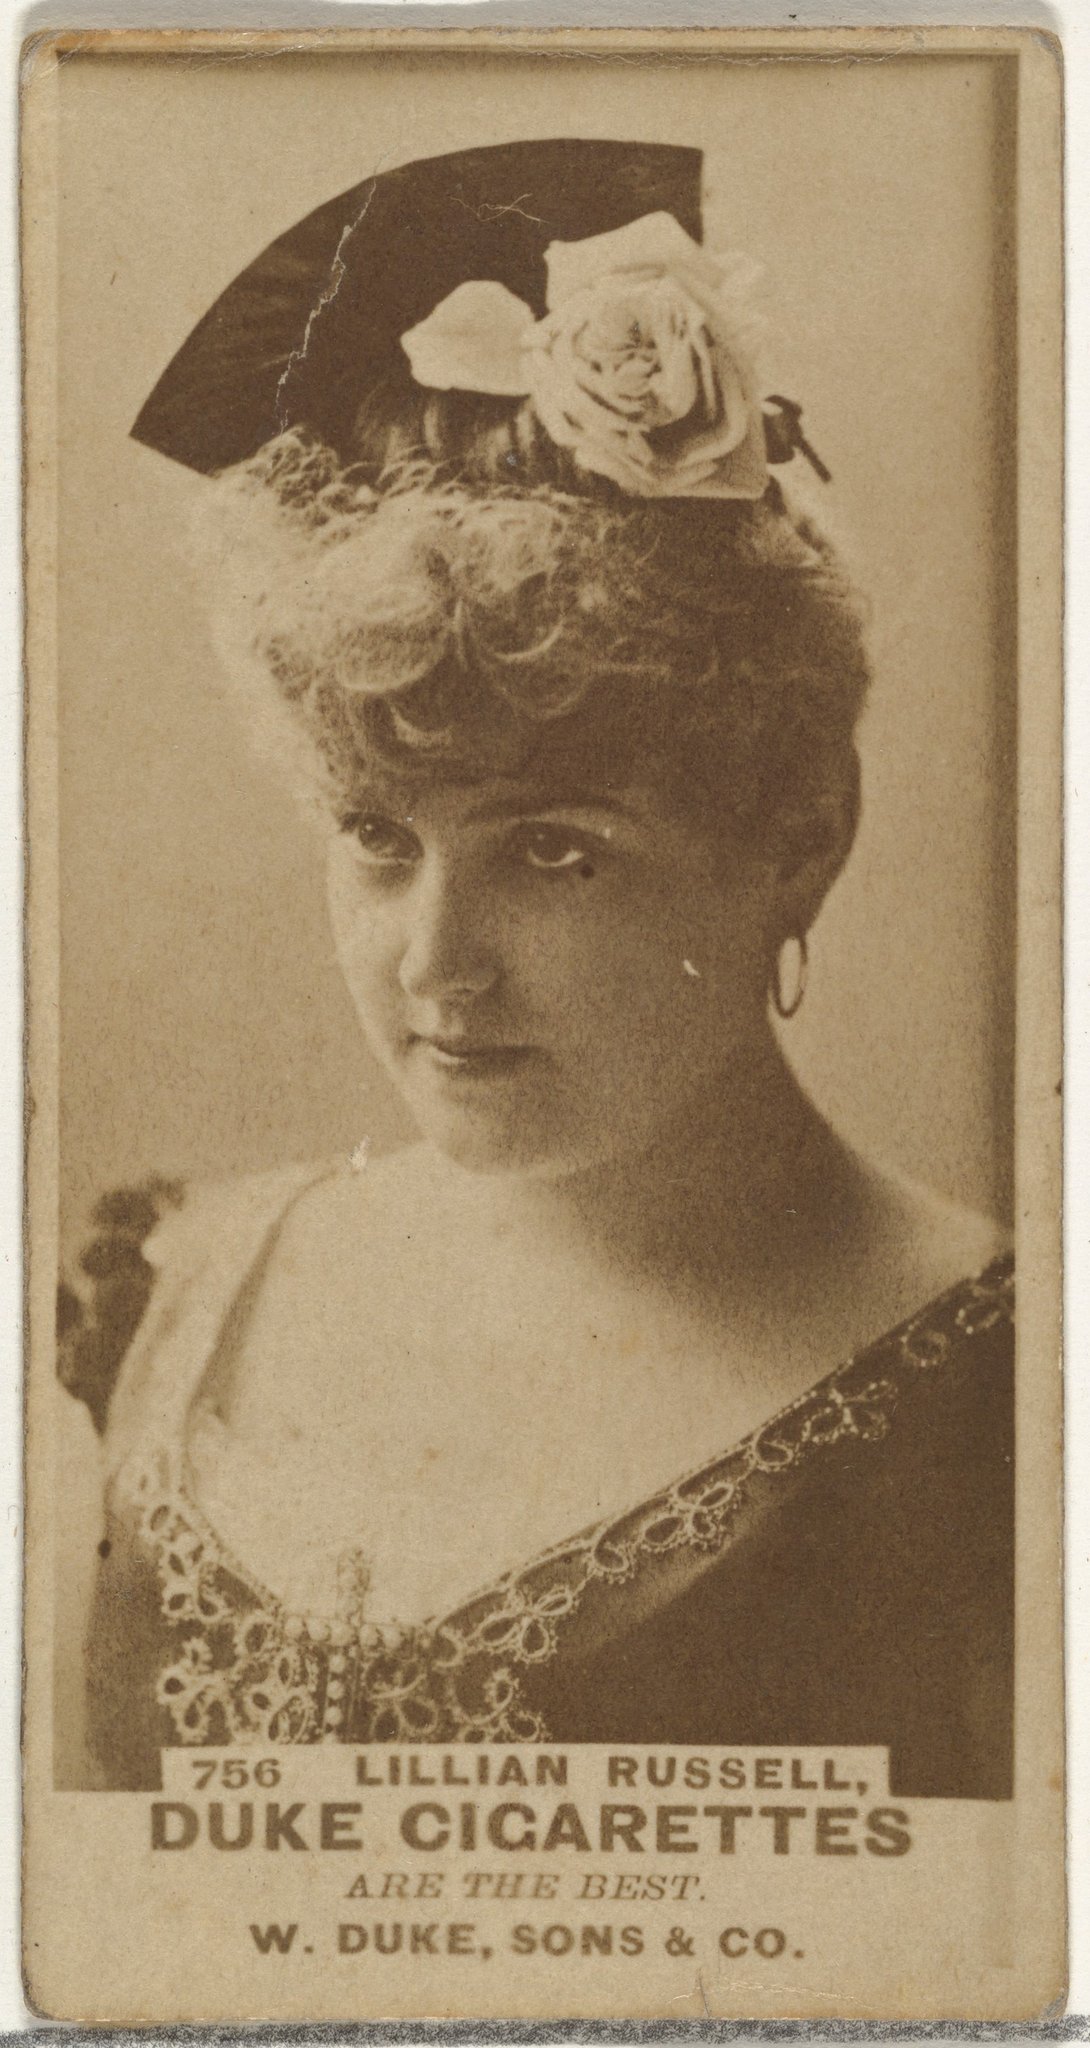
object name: photograph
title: Card Number 756, Lillian Russell, from the Actors and Actresses series (N145-7) issued by Duke Sons & Co. to promote Duke Cigarettes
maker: w. duke, sons & co.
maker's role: publisher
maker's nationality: american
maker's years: 1870-1920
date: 1880-1889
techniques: albumen silver print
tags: portraits,women,actresses